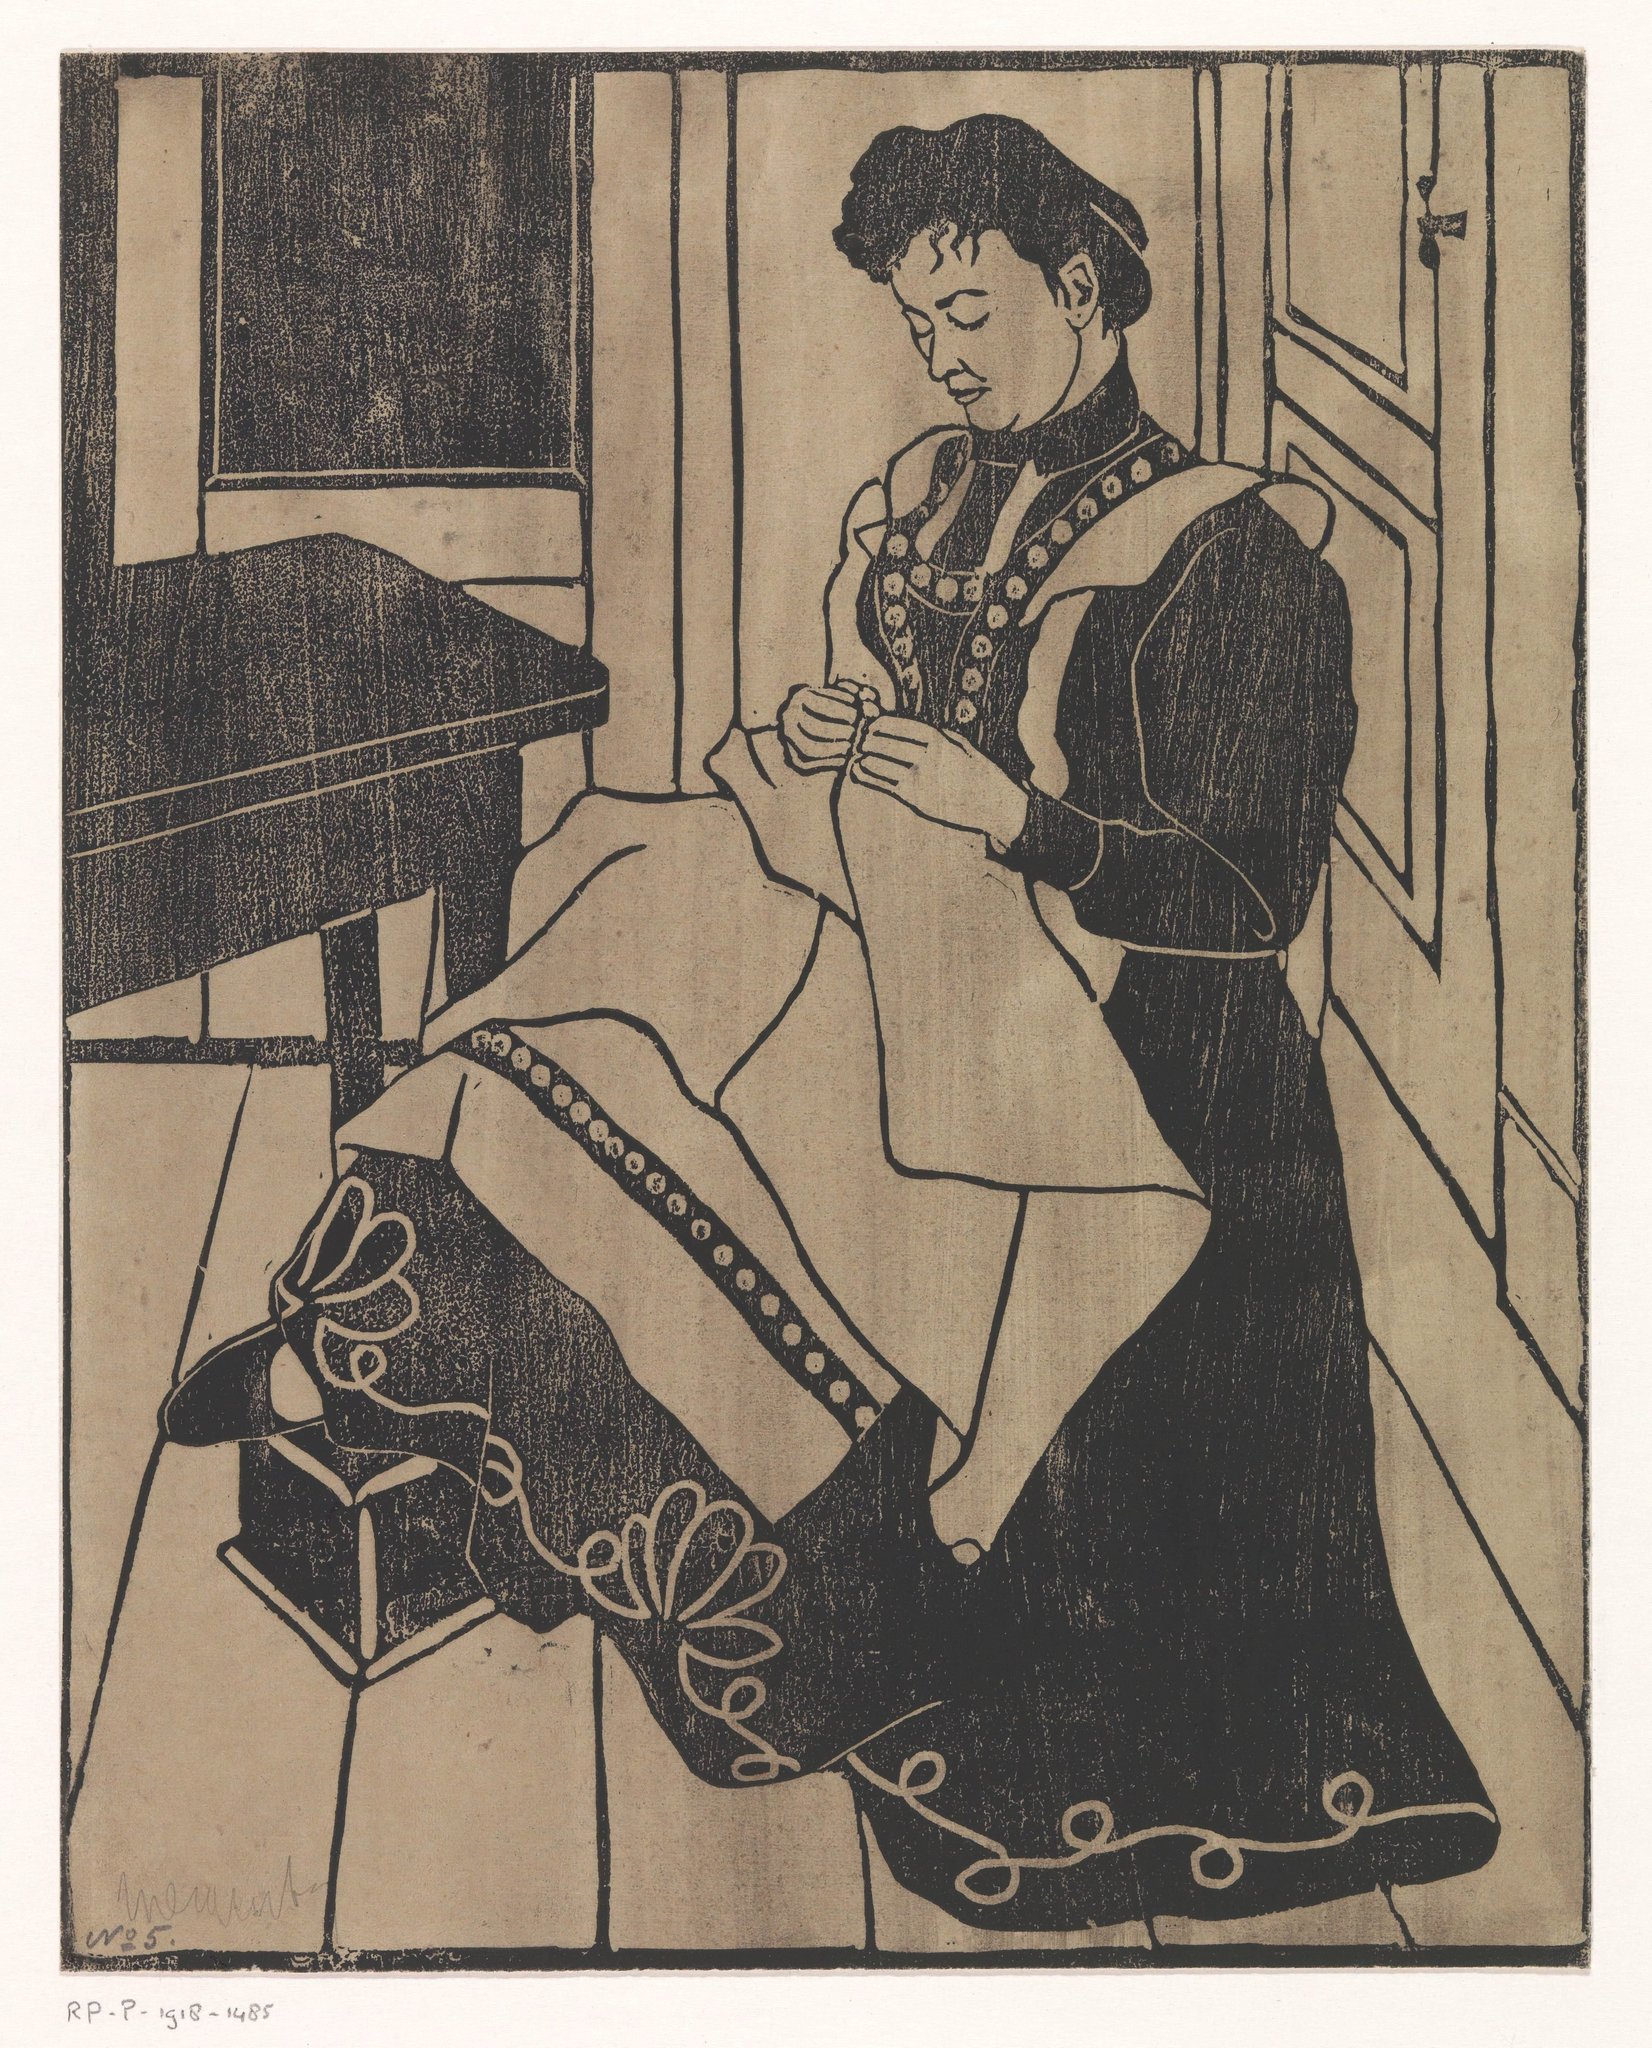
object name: print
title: Naaister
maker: samuel jessurun de mesquita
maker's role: draughtsman, print maker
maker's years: 1868-1944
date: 1899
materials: paper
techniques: woodcut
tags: home sewing; repair of clothes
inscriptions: number: ‘No 5.’, collector's mark: Lugt 2228